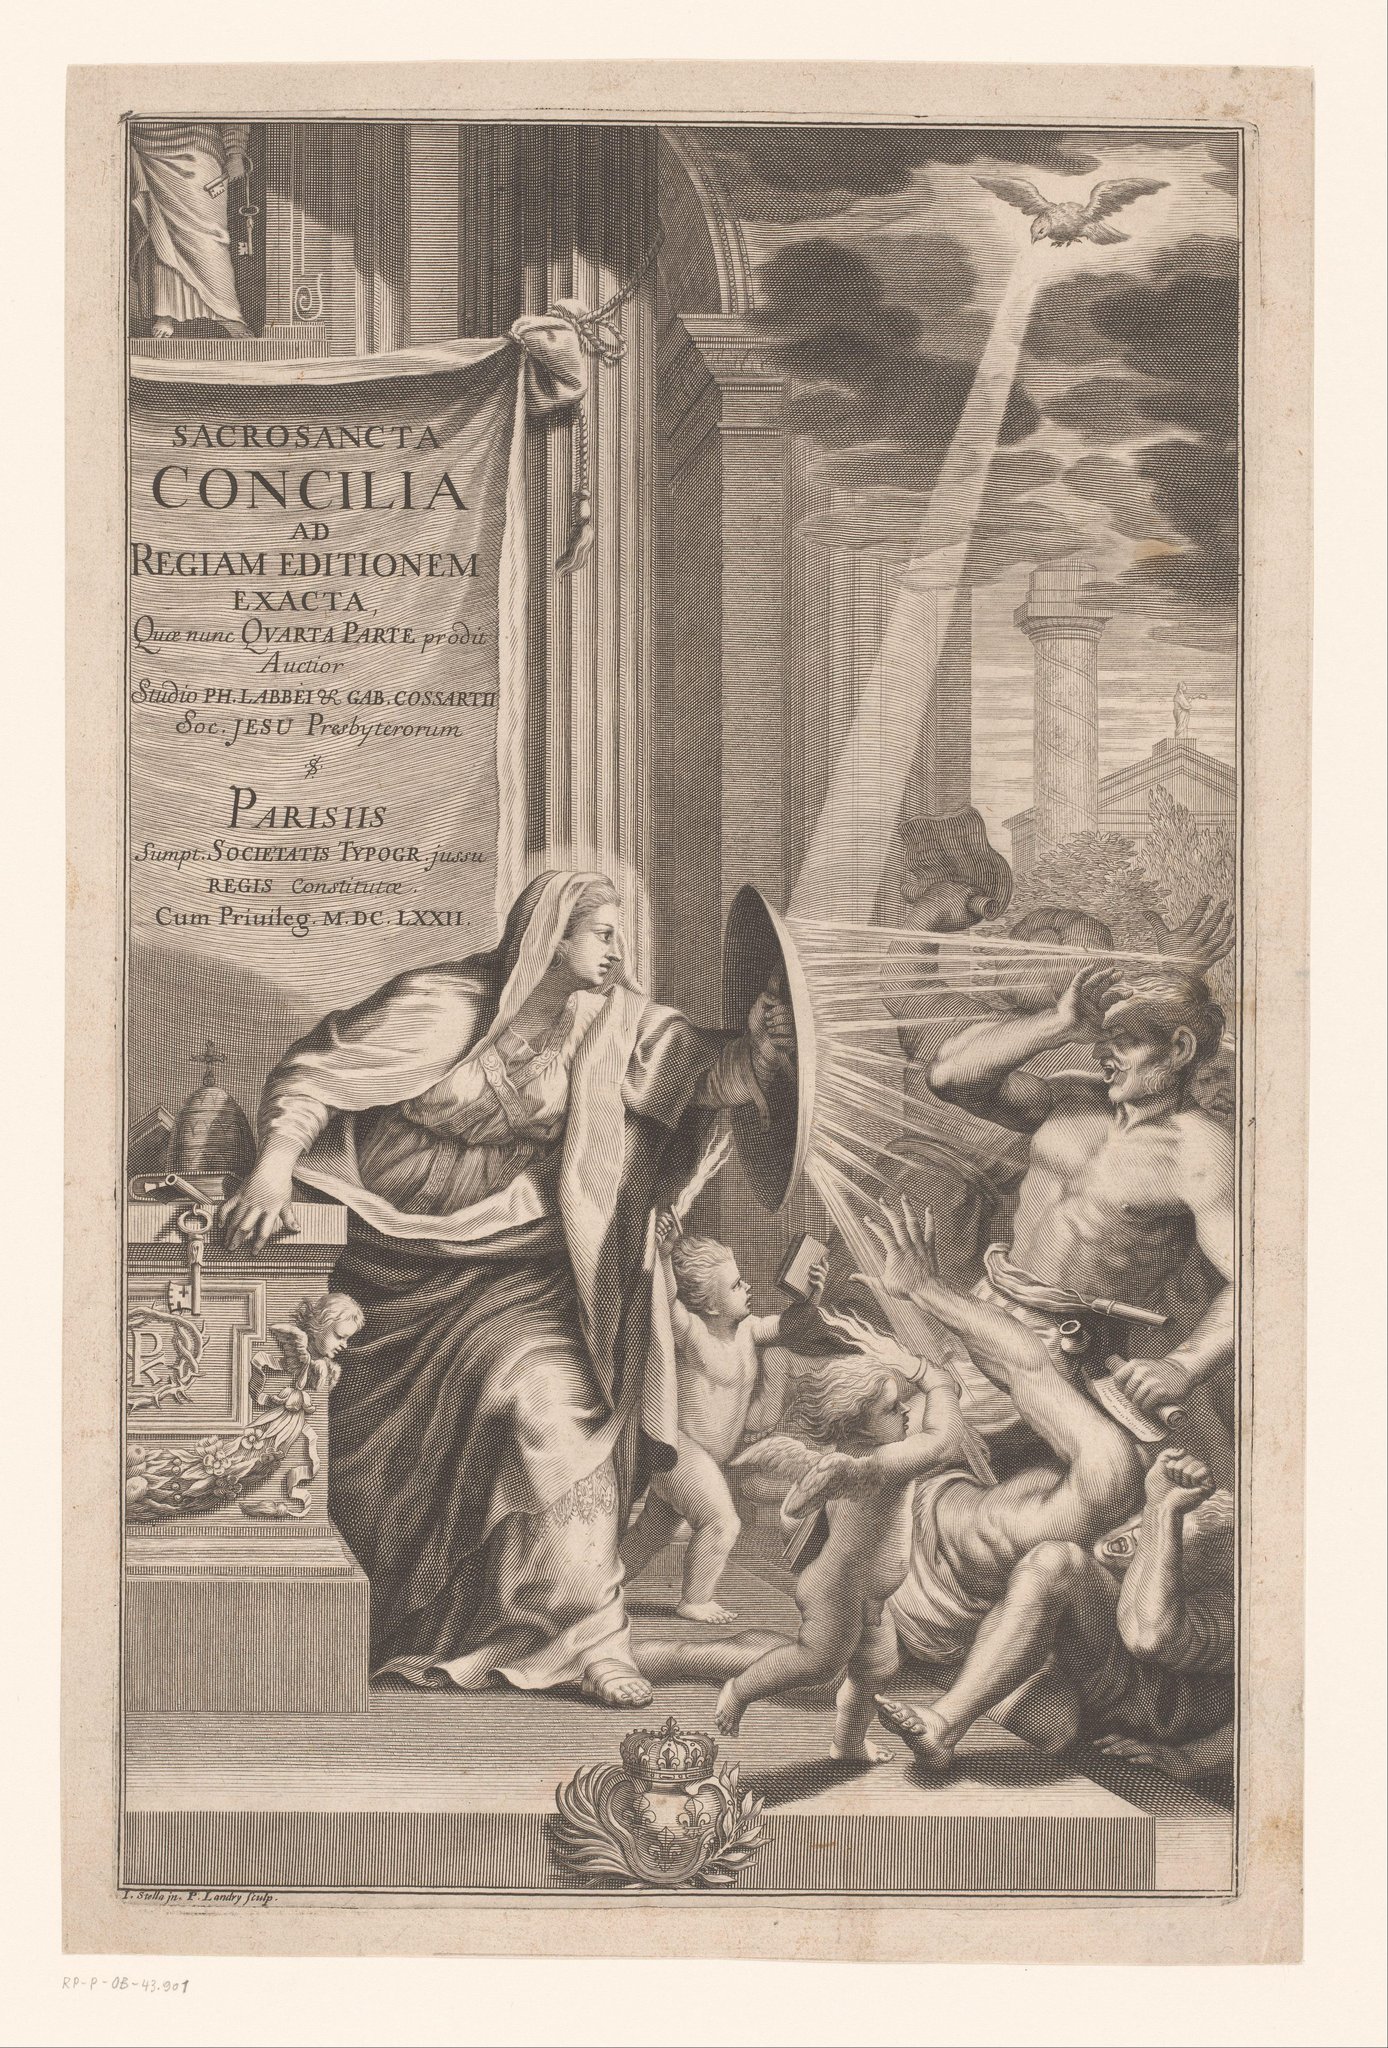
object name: print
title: Personificatie van de christelijke kerk die de heidenen verjaagt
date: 1672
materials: paper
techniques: engraving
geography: france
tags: triumph of the church (or religion)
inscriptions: collector's mark: Lugt 240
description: Titelpagina voor: Labbé, Philippe en Cossart, Gabriel. Sacrosancta Concilia ad Regiam Editionem Exacta. Parijs: s.n. 1642.